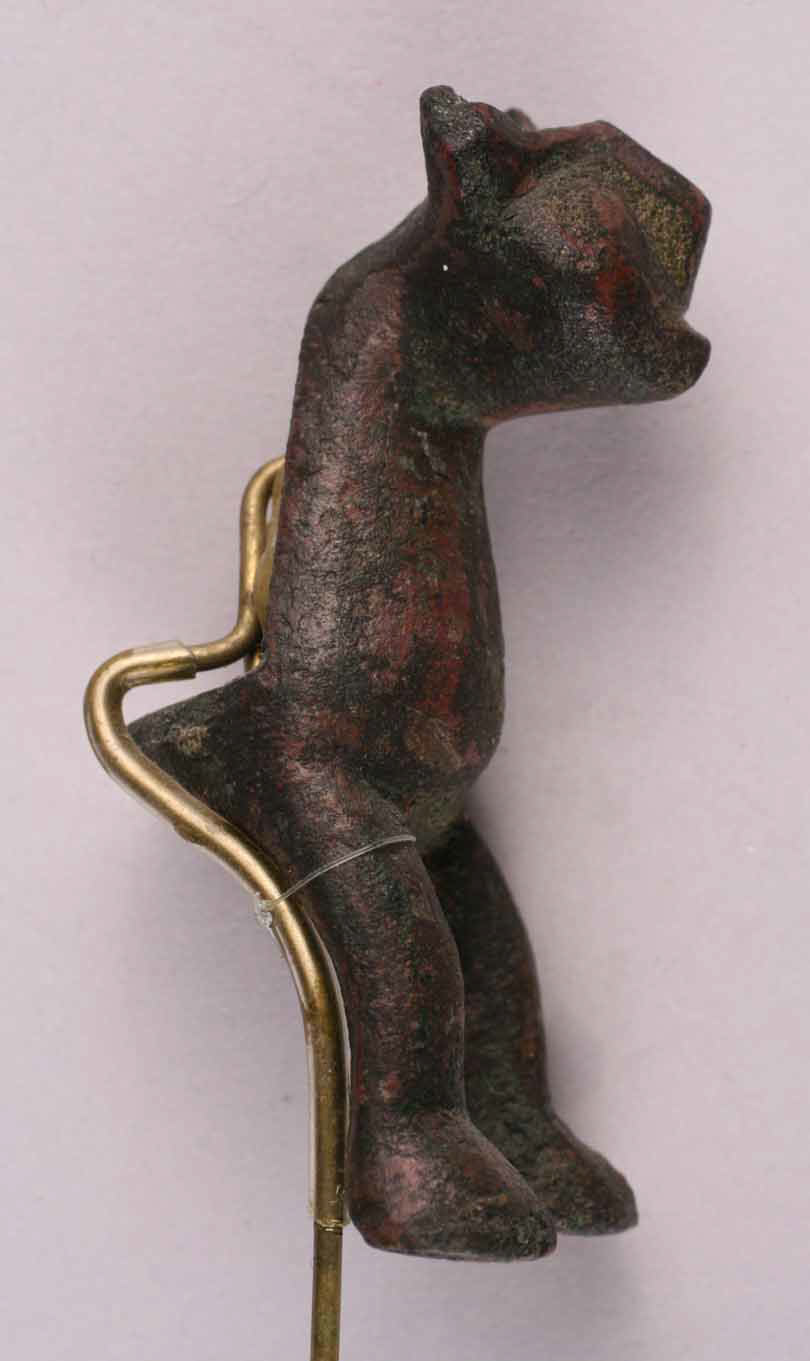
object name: support fitting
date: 901-1000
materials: bronze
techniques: casting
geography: iran